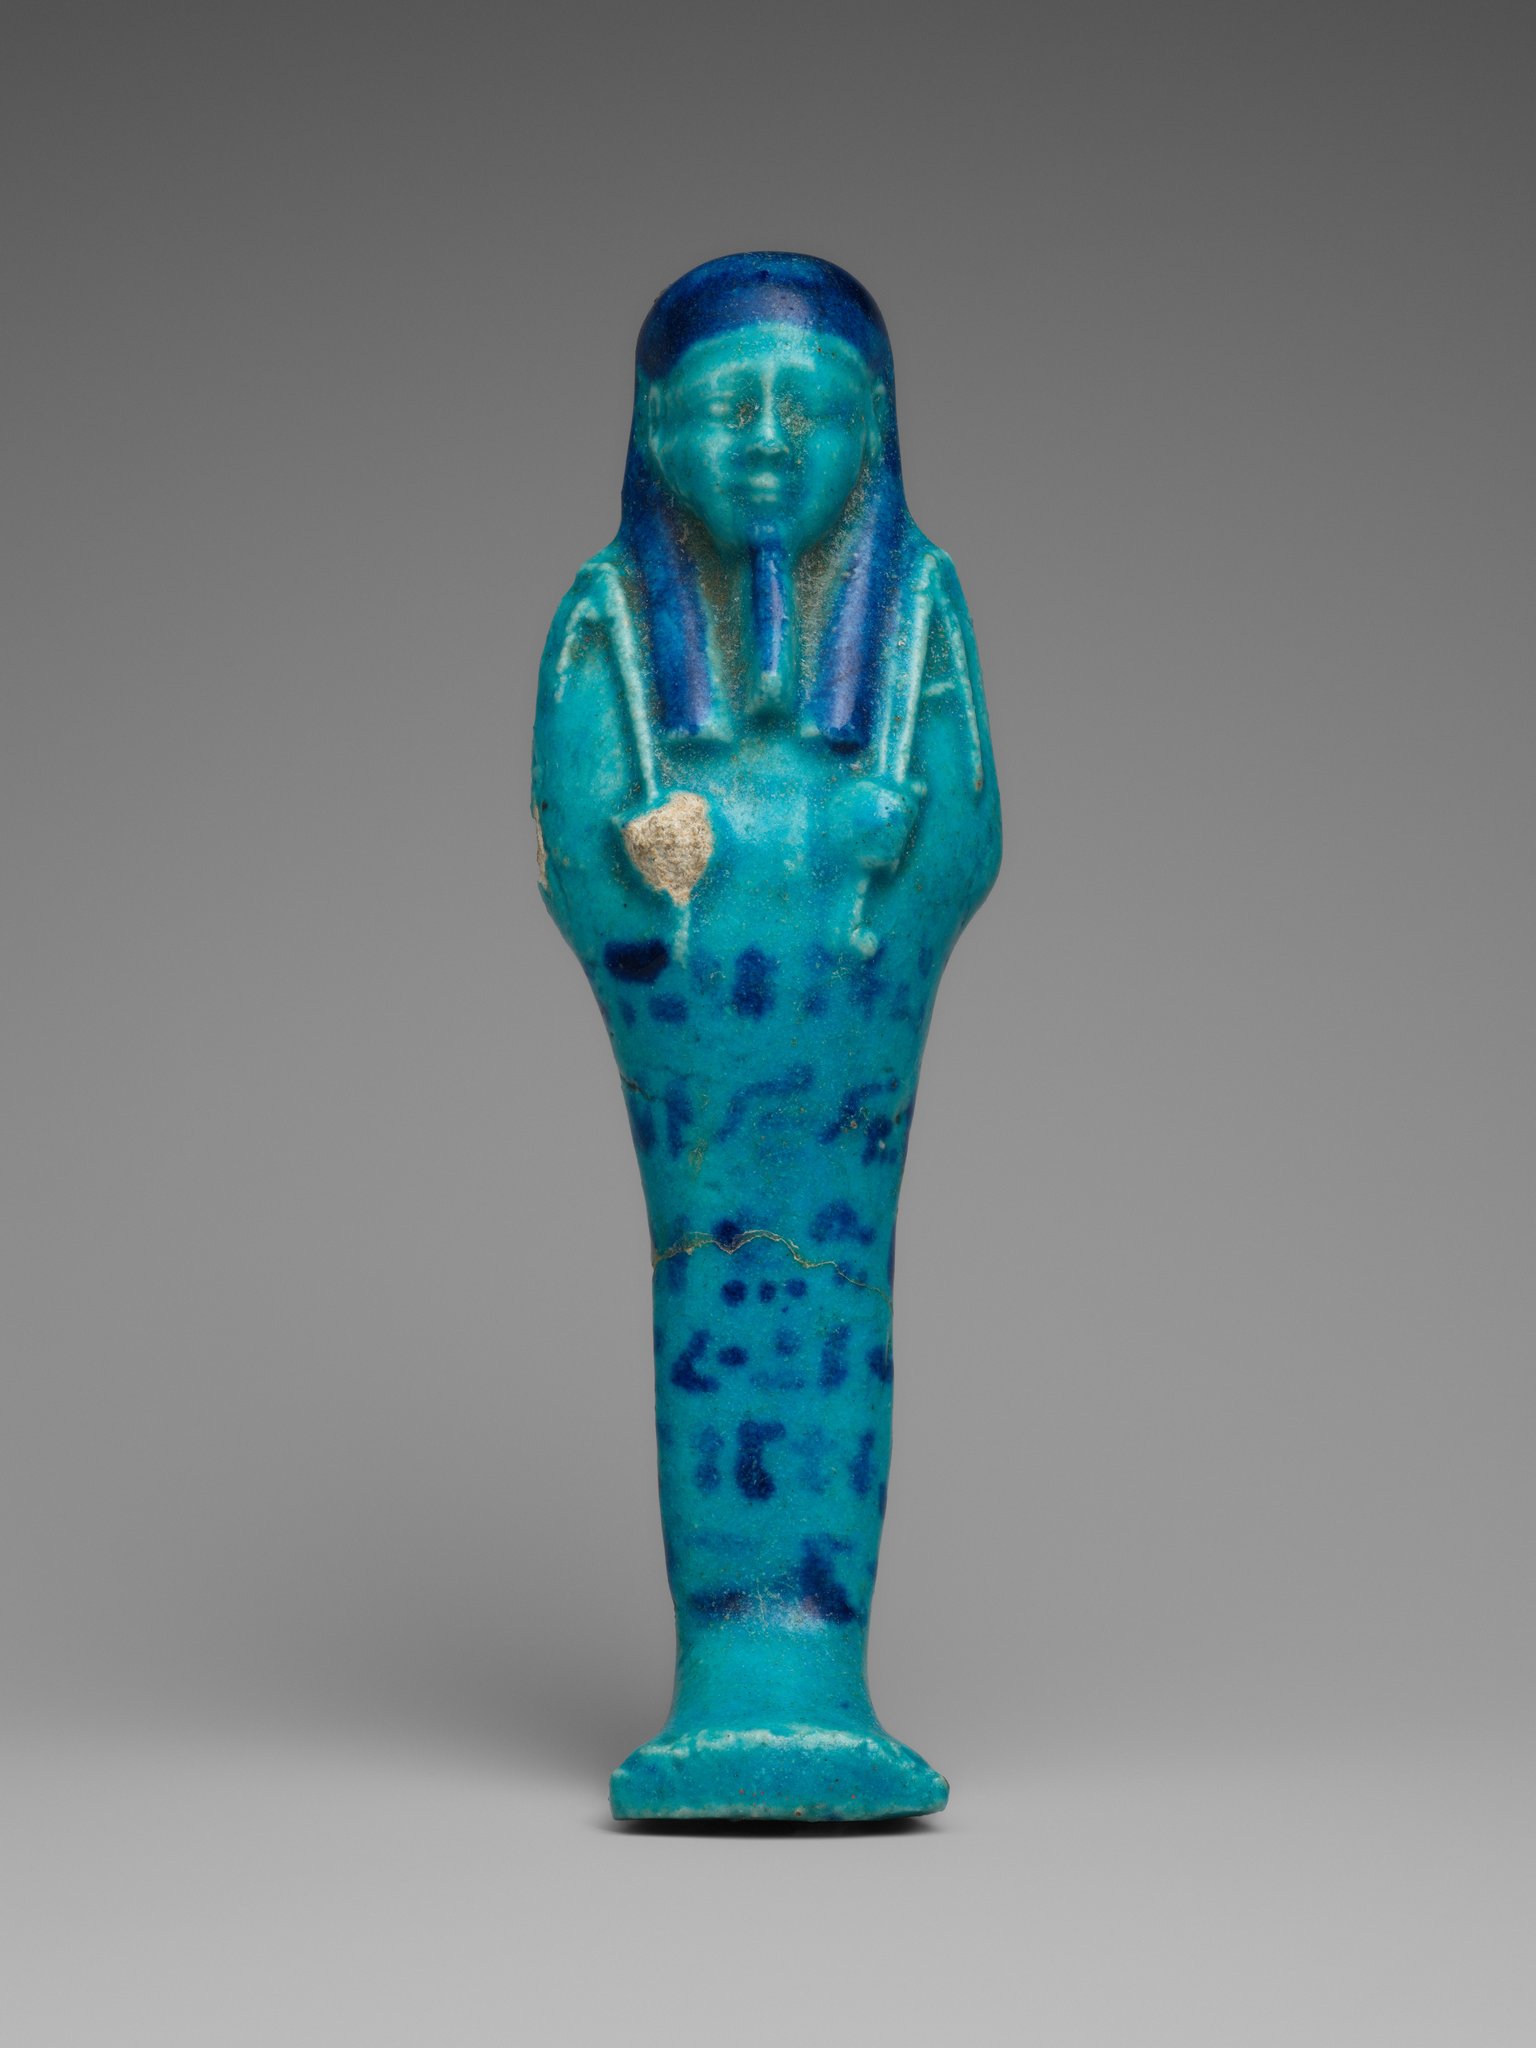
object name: shabti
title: Shabti of Padinisut(?)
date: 664-343 BCE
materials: faience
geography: egypt